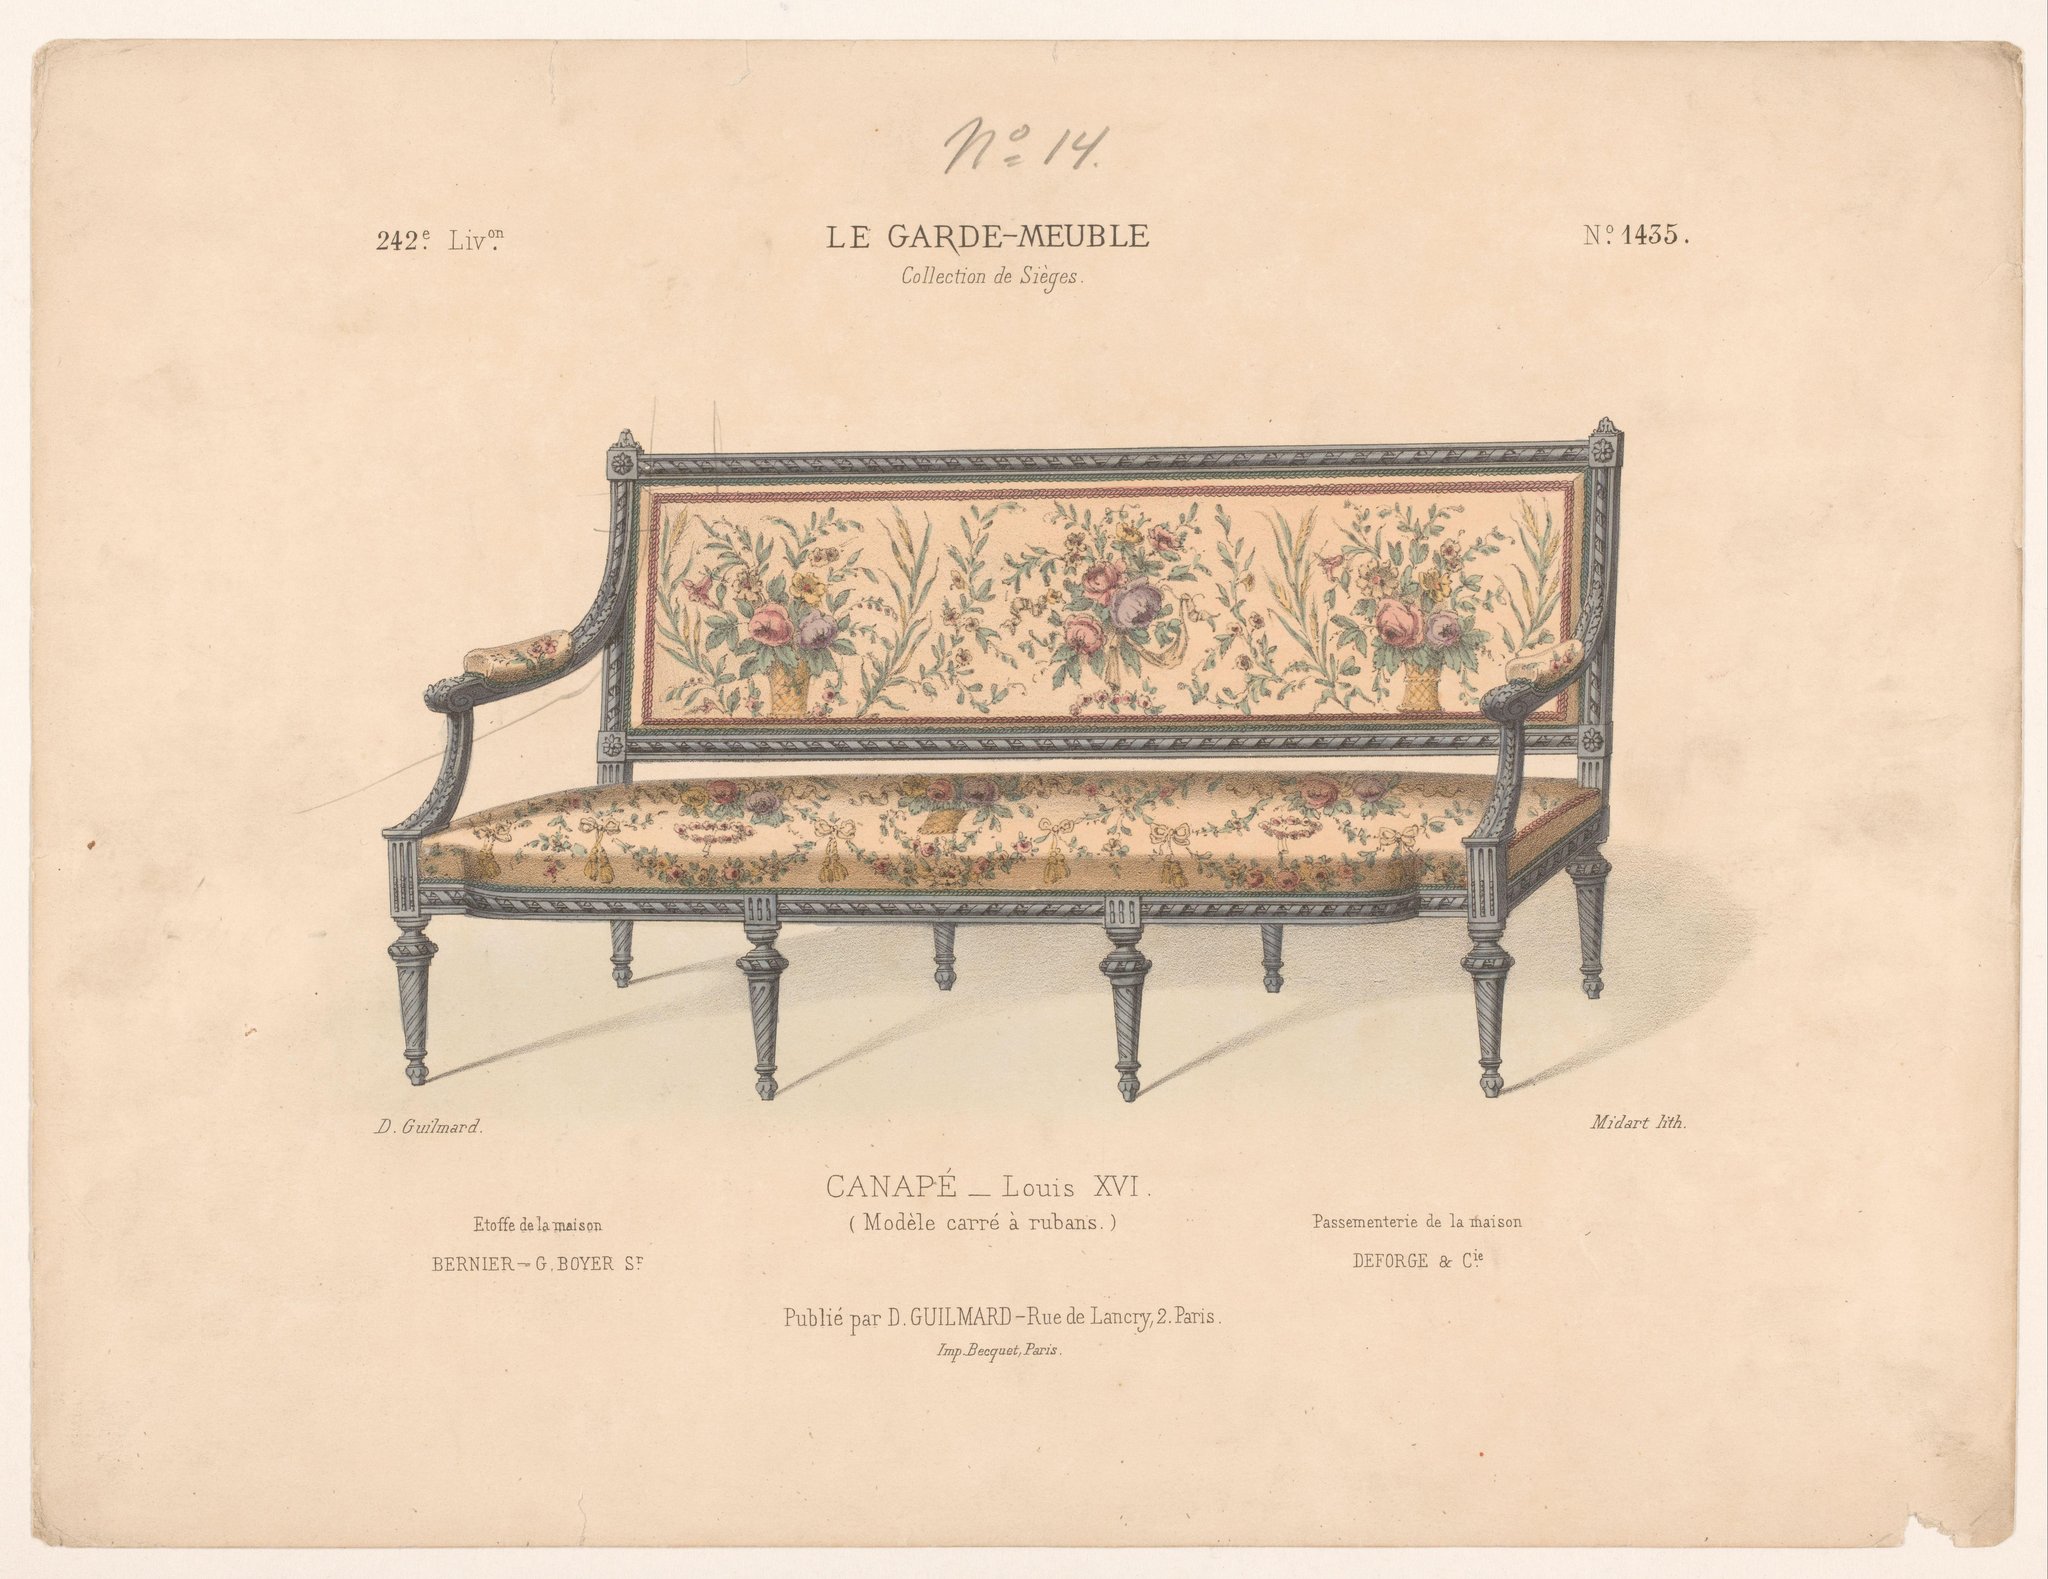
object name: print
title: Le garde-meuble / Collection de Sièges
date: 1839-1885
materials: paper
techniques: hand coloring, lithograph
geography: paris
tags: seating furniture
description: Ieder Livraison in de serie Le Garde-Meuble bevat negen platen: drie 'sièges' (zitmeubels), drie 'meubles' (diverse meubels zoals tafels en kasten) en drie 'tentures' (gordijnen en draperieën).